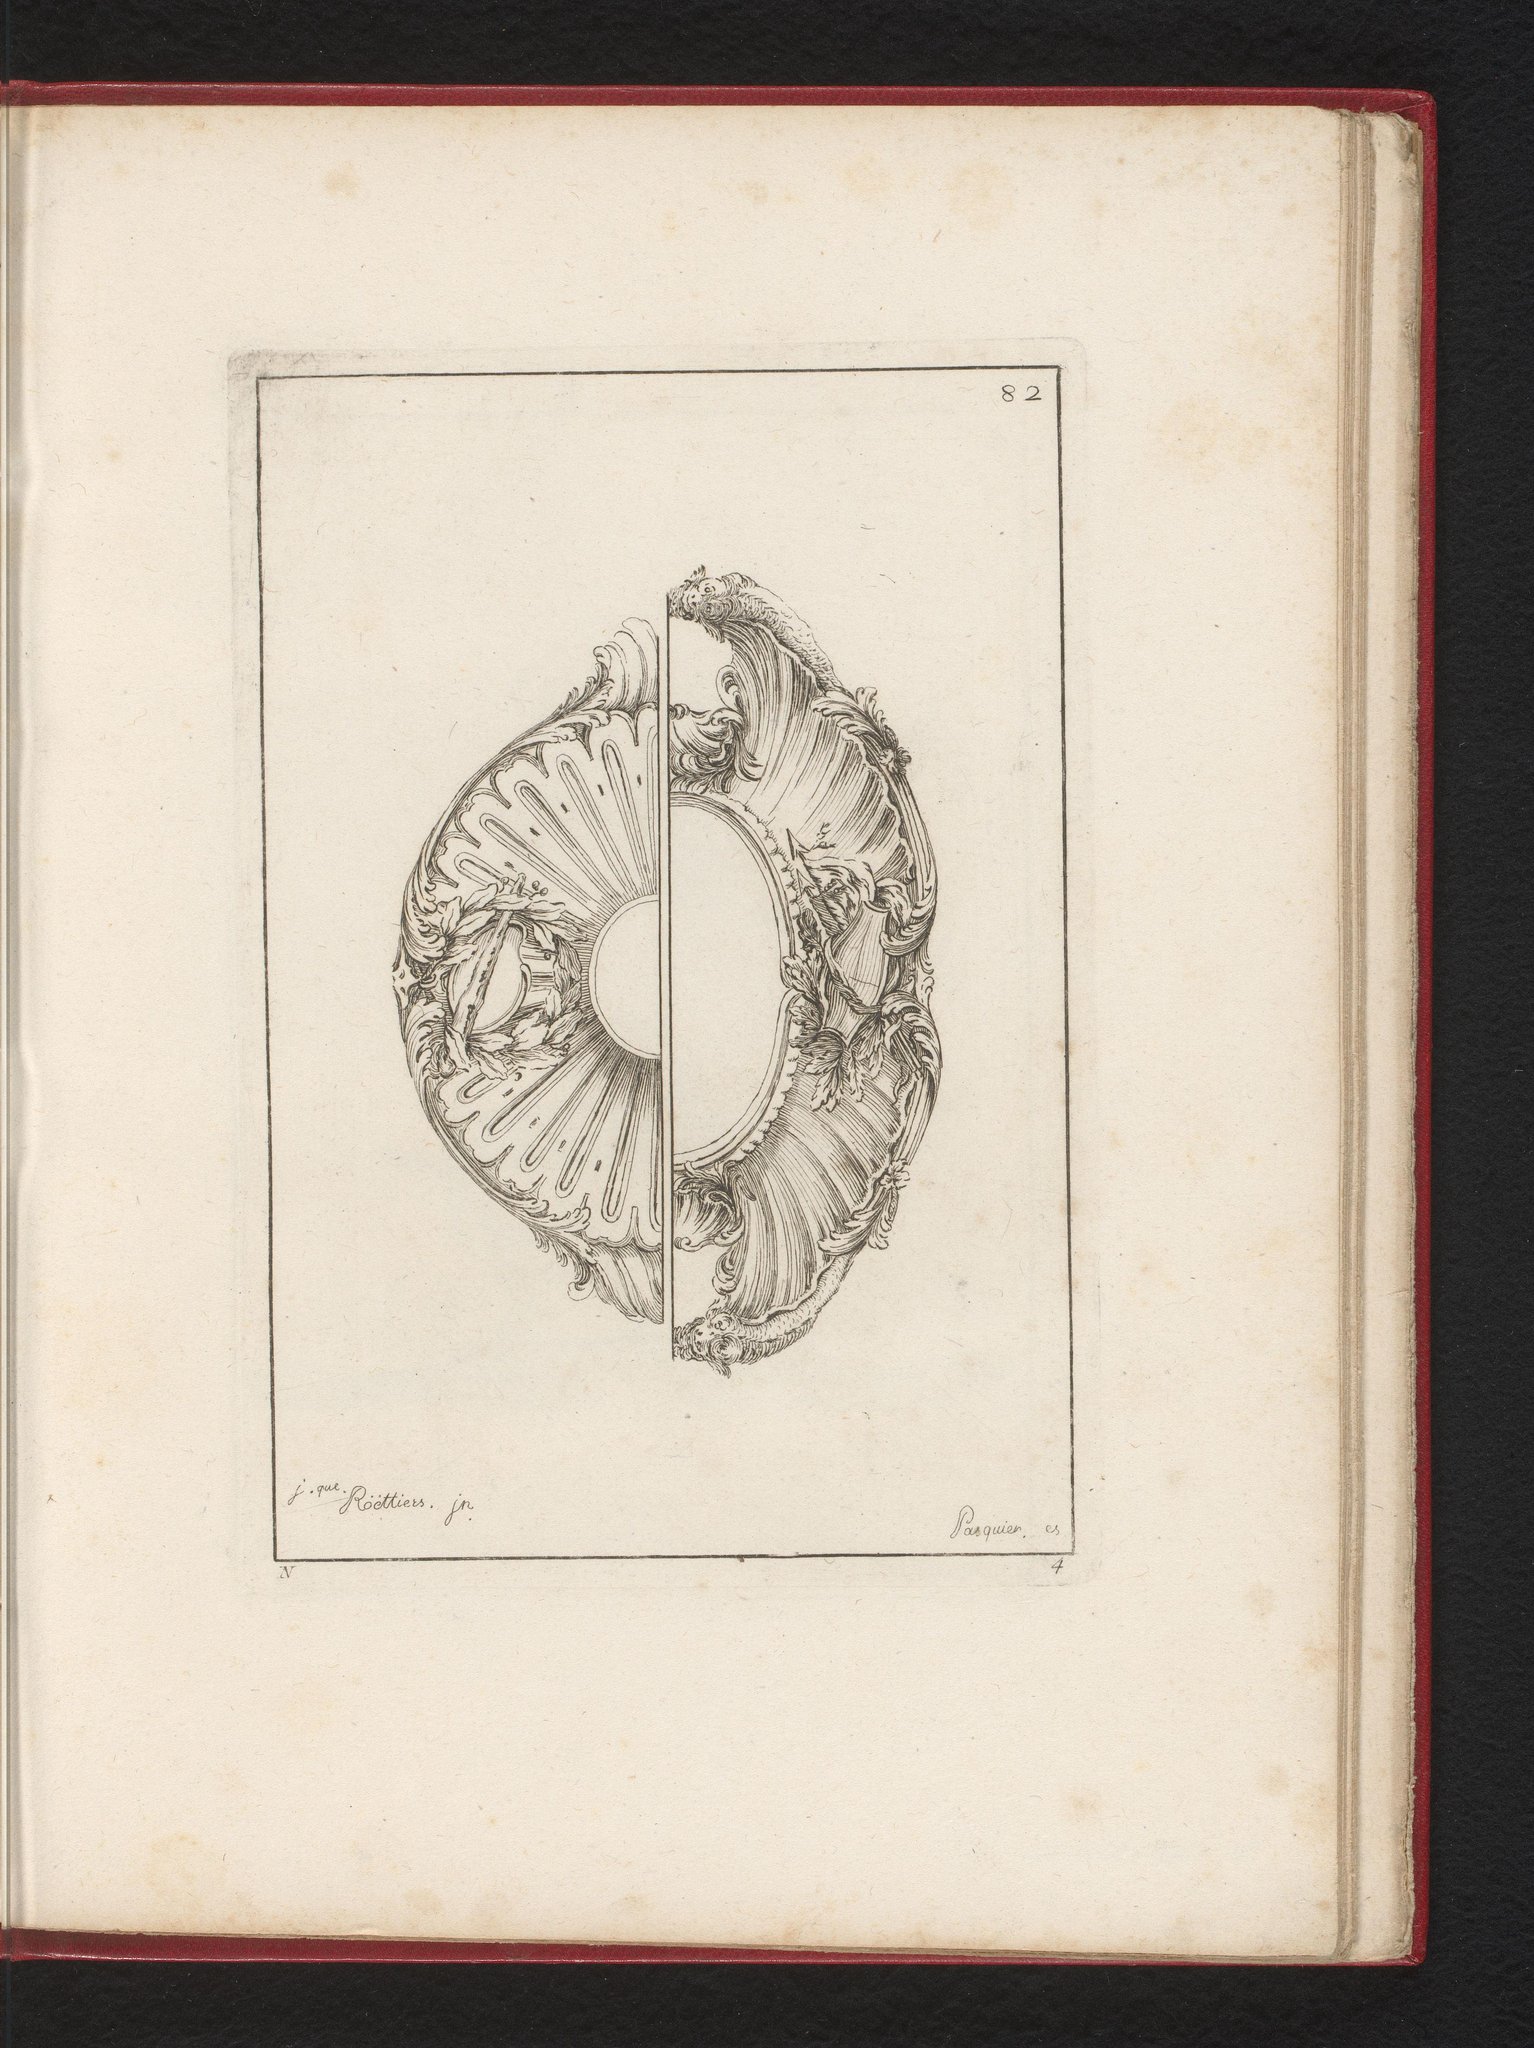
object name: print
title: Elements d'orfevrerie divisés en deux parties de cinquante feuilles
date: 1748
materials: paper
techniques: etching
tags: serving-dish, platter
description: Een aantal van de objecten in deze reeks heeft een eigen ondertitel, die verwijst naar genummerde 'cahiers' (afleveringen) waarin de prenten werden uitgegeven. Het is onduidelijk welke objecten recies bij welke aflevering horen. Daarom is die ondertitel enkel verwerkt bij de prent waarop die voorkomt.